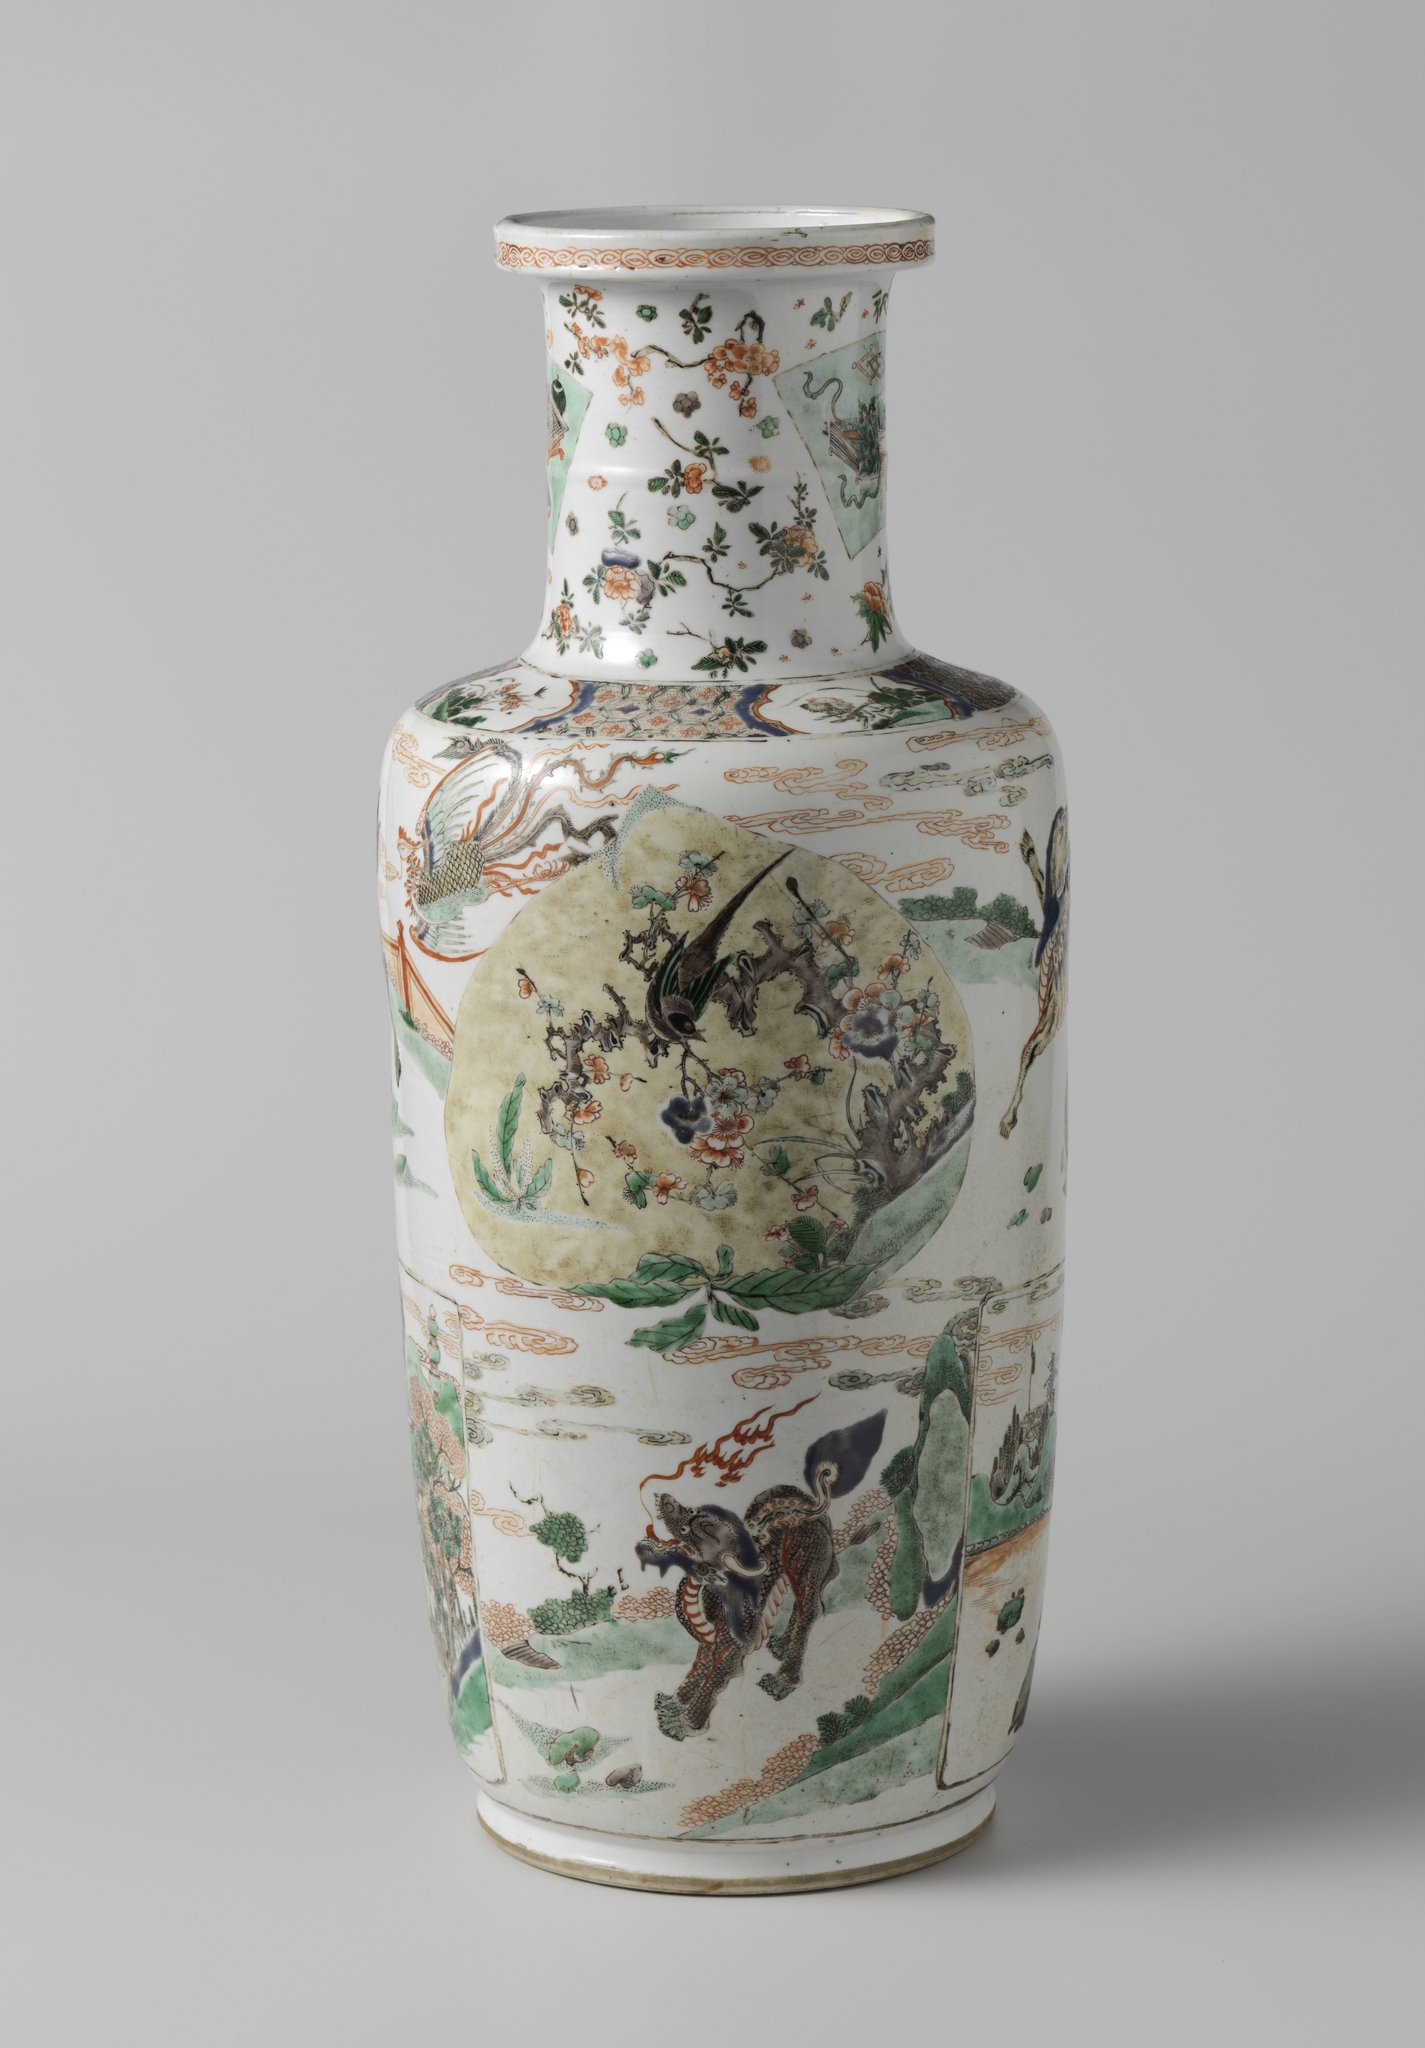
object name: vase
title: Vase with (mythological) animals in landscapes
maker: Anonymous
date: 1675-1699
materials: glaze, gold, paint, porcelain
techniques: firing, gilding, turning, vitrification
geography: china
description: Cilindervormige vaas van porselein met een brede nek en opstaande rand, beschilderd op het glazuur in blauw, rood, groen, geel, aubergine, zwart en goud. Op de wand een landschap met (mythologische) dieren (feng huang, shishi, draak, qilin, tijger), onderbroken door twee cartouches met rivierlandschappen met pijnboom en paviljoens en twee perzikvormige cartouches met een vogel op een bloemtak (prunus, magnolia). Op de schouder een band servetwerk onderbroken door bloeiende planten in cartouches. De nek met losse bloemtakken en twee waaiervormige cartouches met antiquiteiten (boeken, rol, ruyi-scepter, qin, objecten van een geleerde, go-bord, artemisiablad). De buitenrand met een band krulwerk. Famille verte.